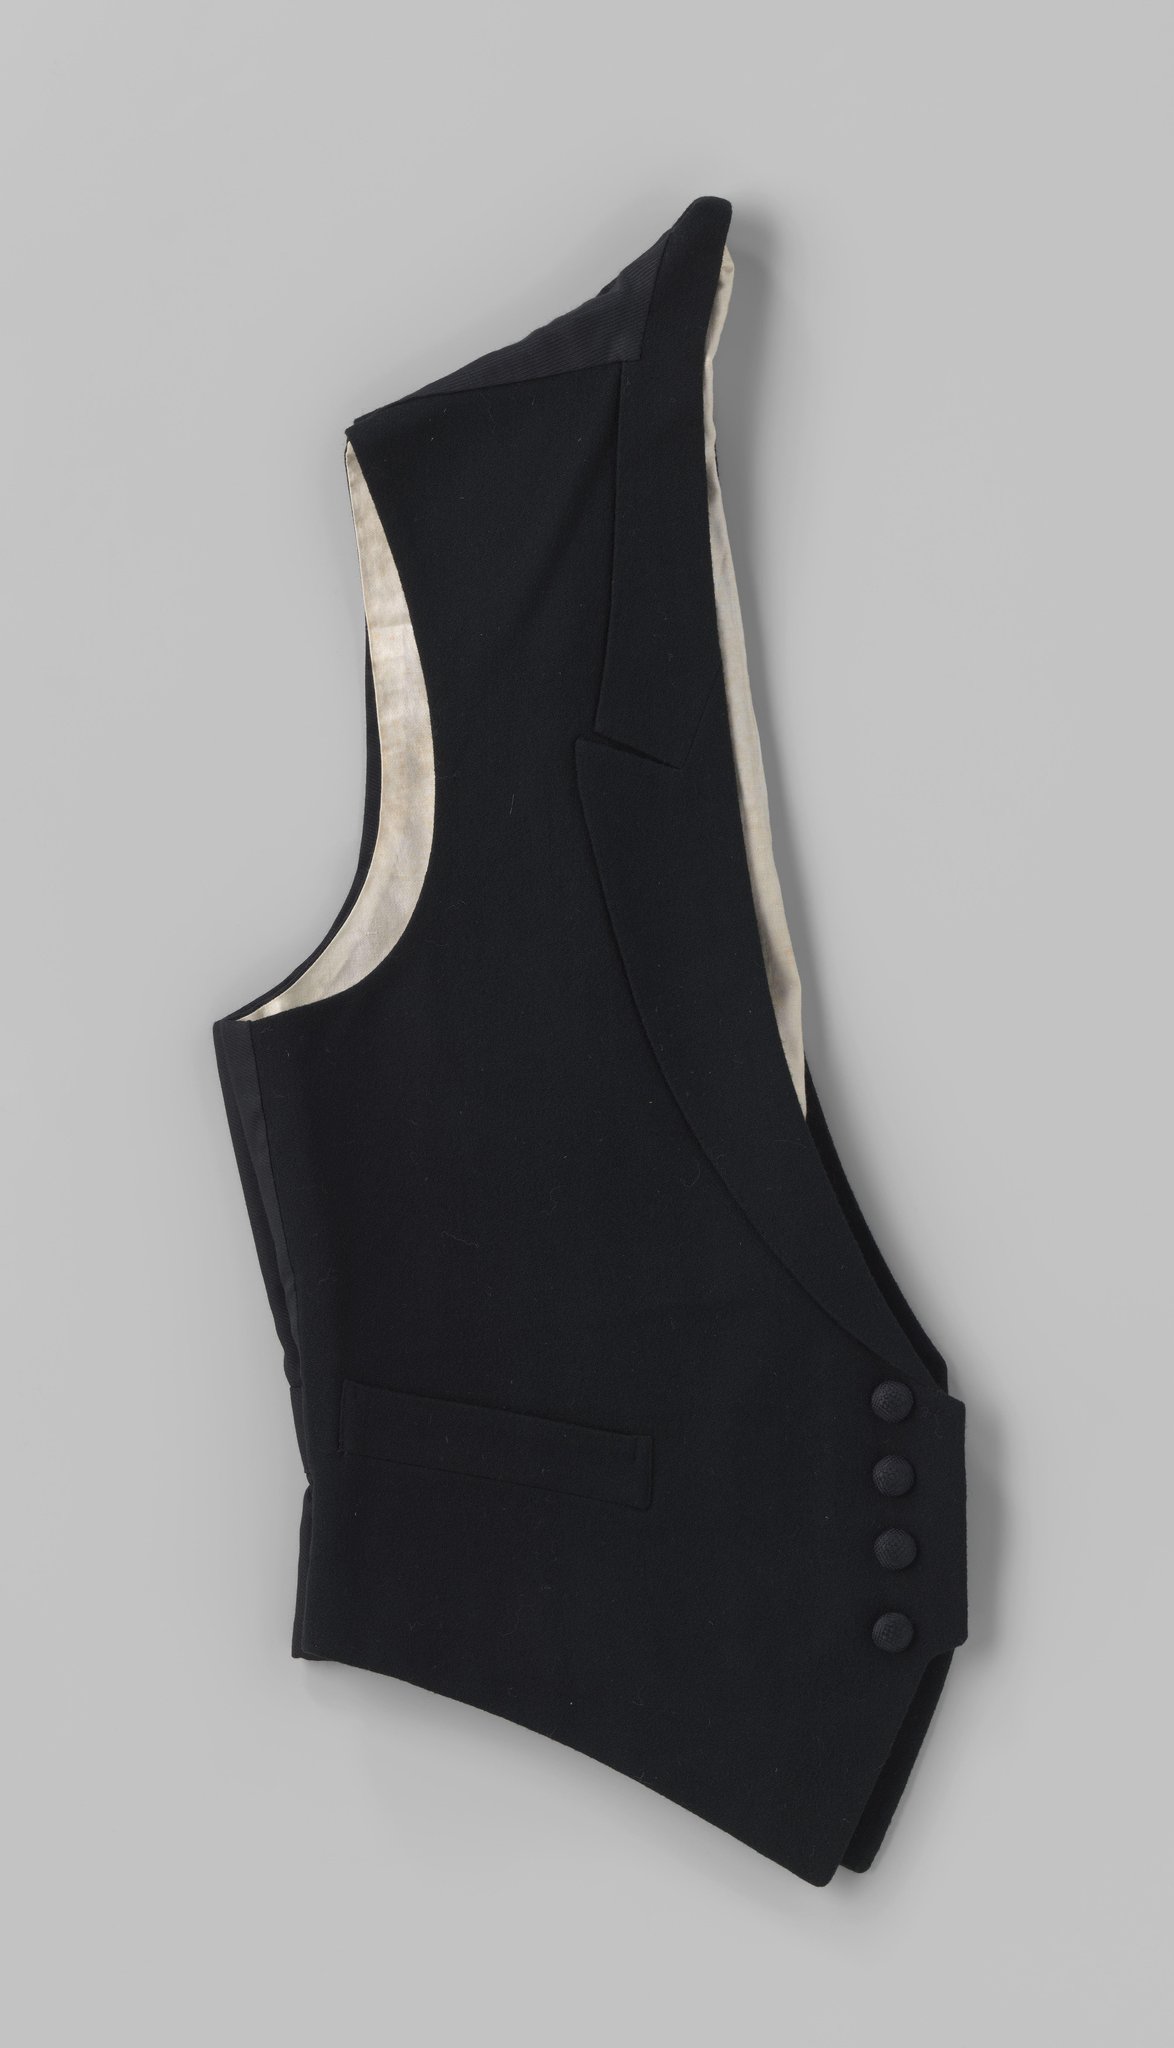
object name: main garment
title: Vest met diepe V-hals met sjaalkraag van zwarte wol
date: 1910-1915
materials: wool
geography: utrecht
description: Adres: Bunschoten en de Gooijer/hofleveranciers/Utrecht; in inkt gemerkt: jhr. Gevers/cie. 5658.